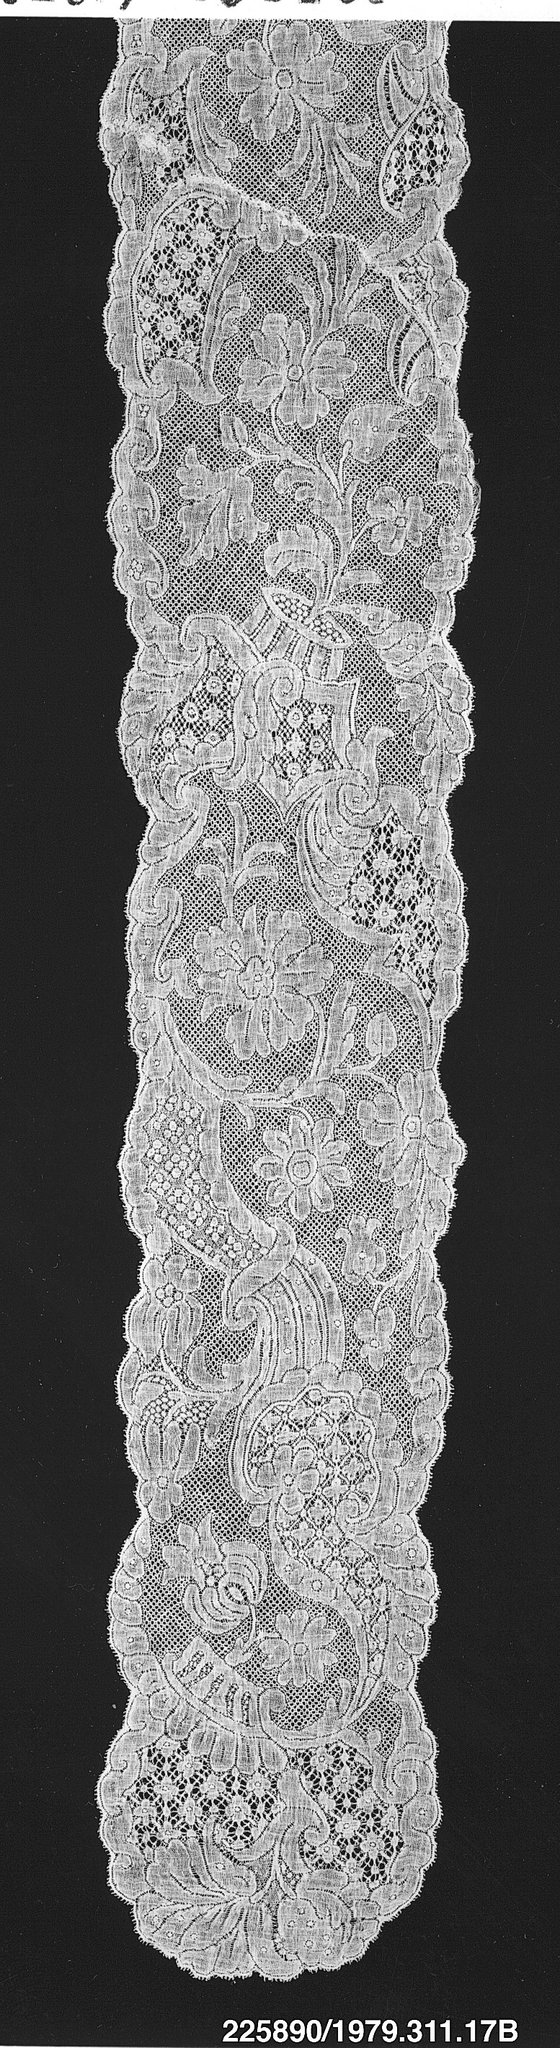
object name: lappet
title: Lappets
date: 1701-1750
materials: linen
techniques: lace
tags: flowers